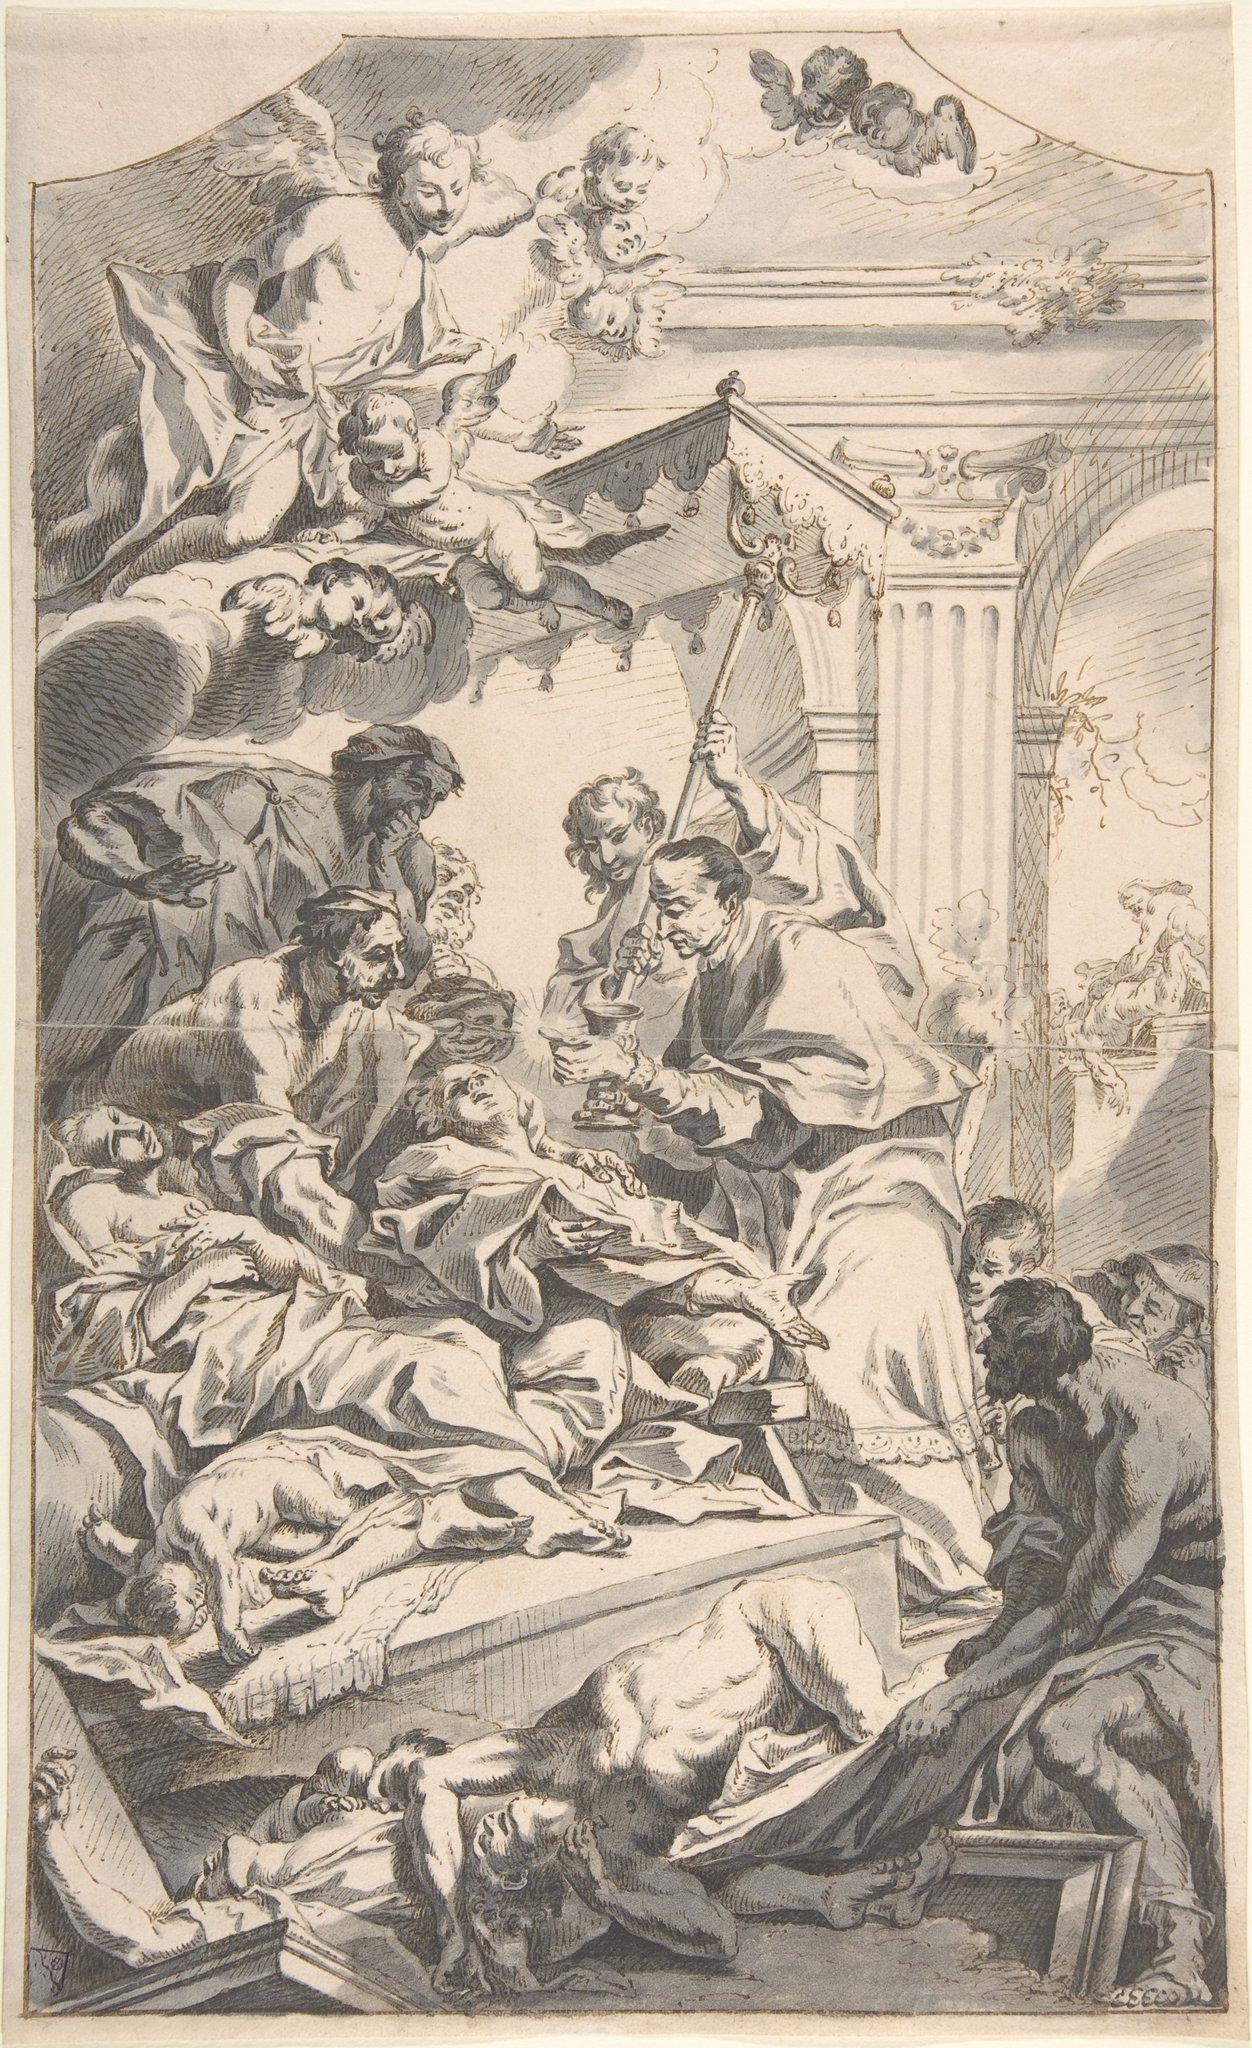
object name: drawing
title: Saint Carl Borromäus Giving Extreme Unction to the Plague-Stricken.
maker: johann daniel herz the elder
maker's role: artist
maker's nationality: german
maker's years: 1693-1754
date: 1700-1754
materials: ink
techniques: brush, pen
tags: men,women,angels,saints